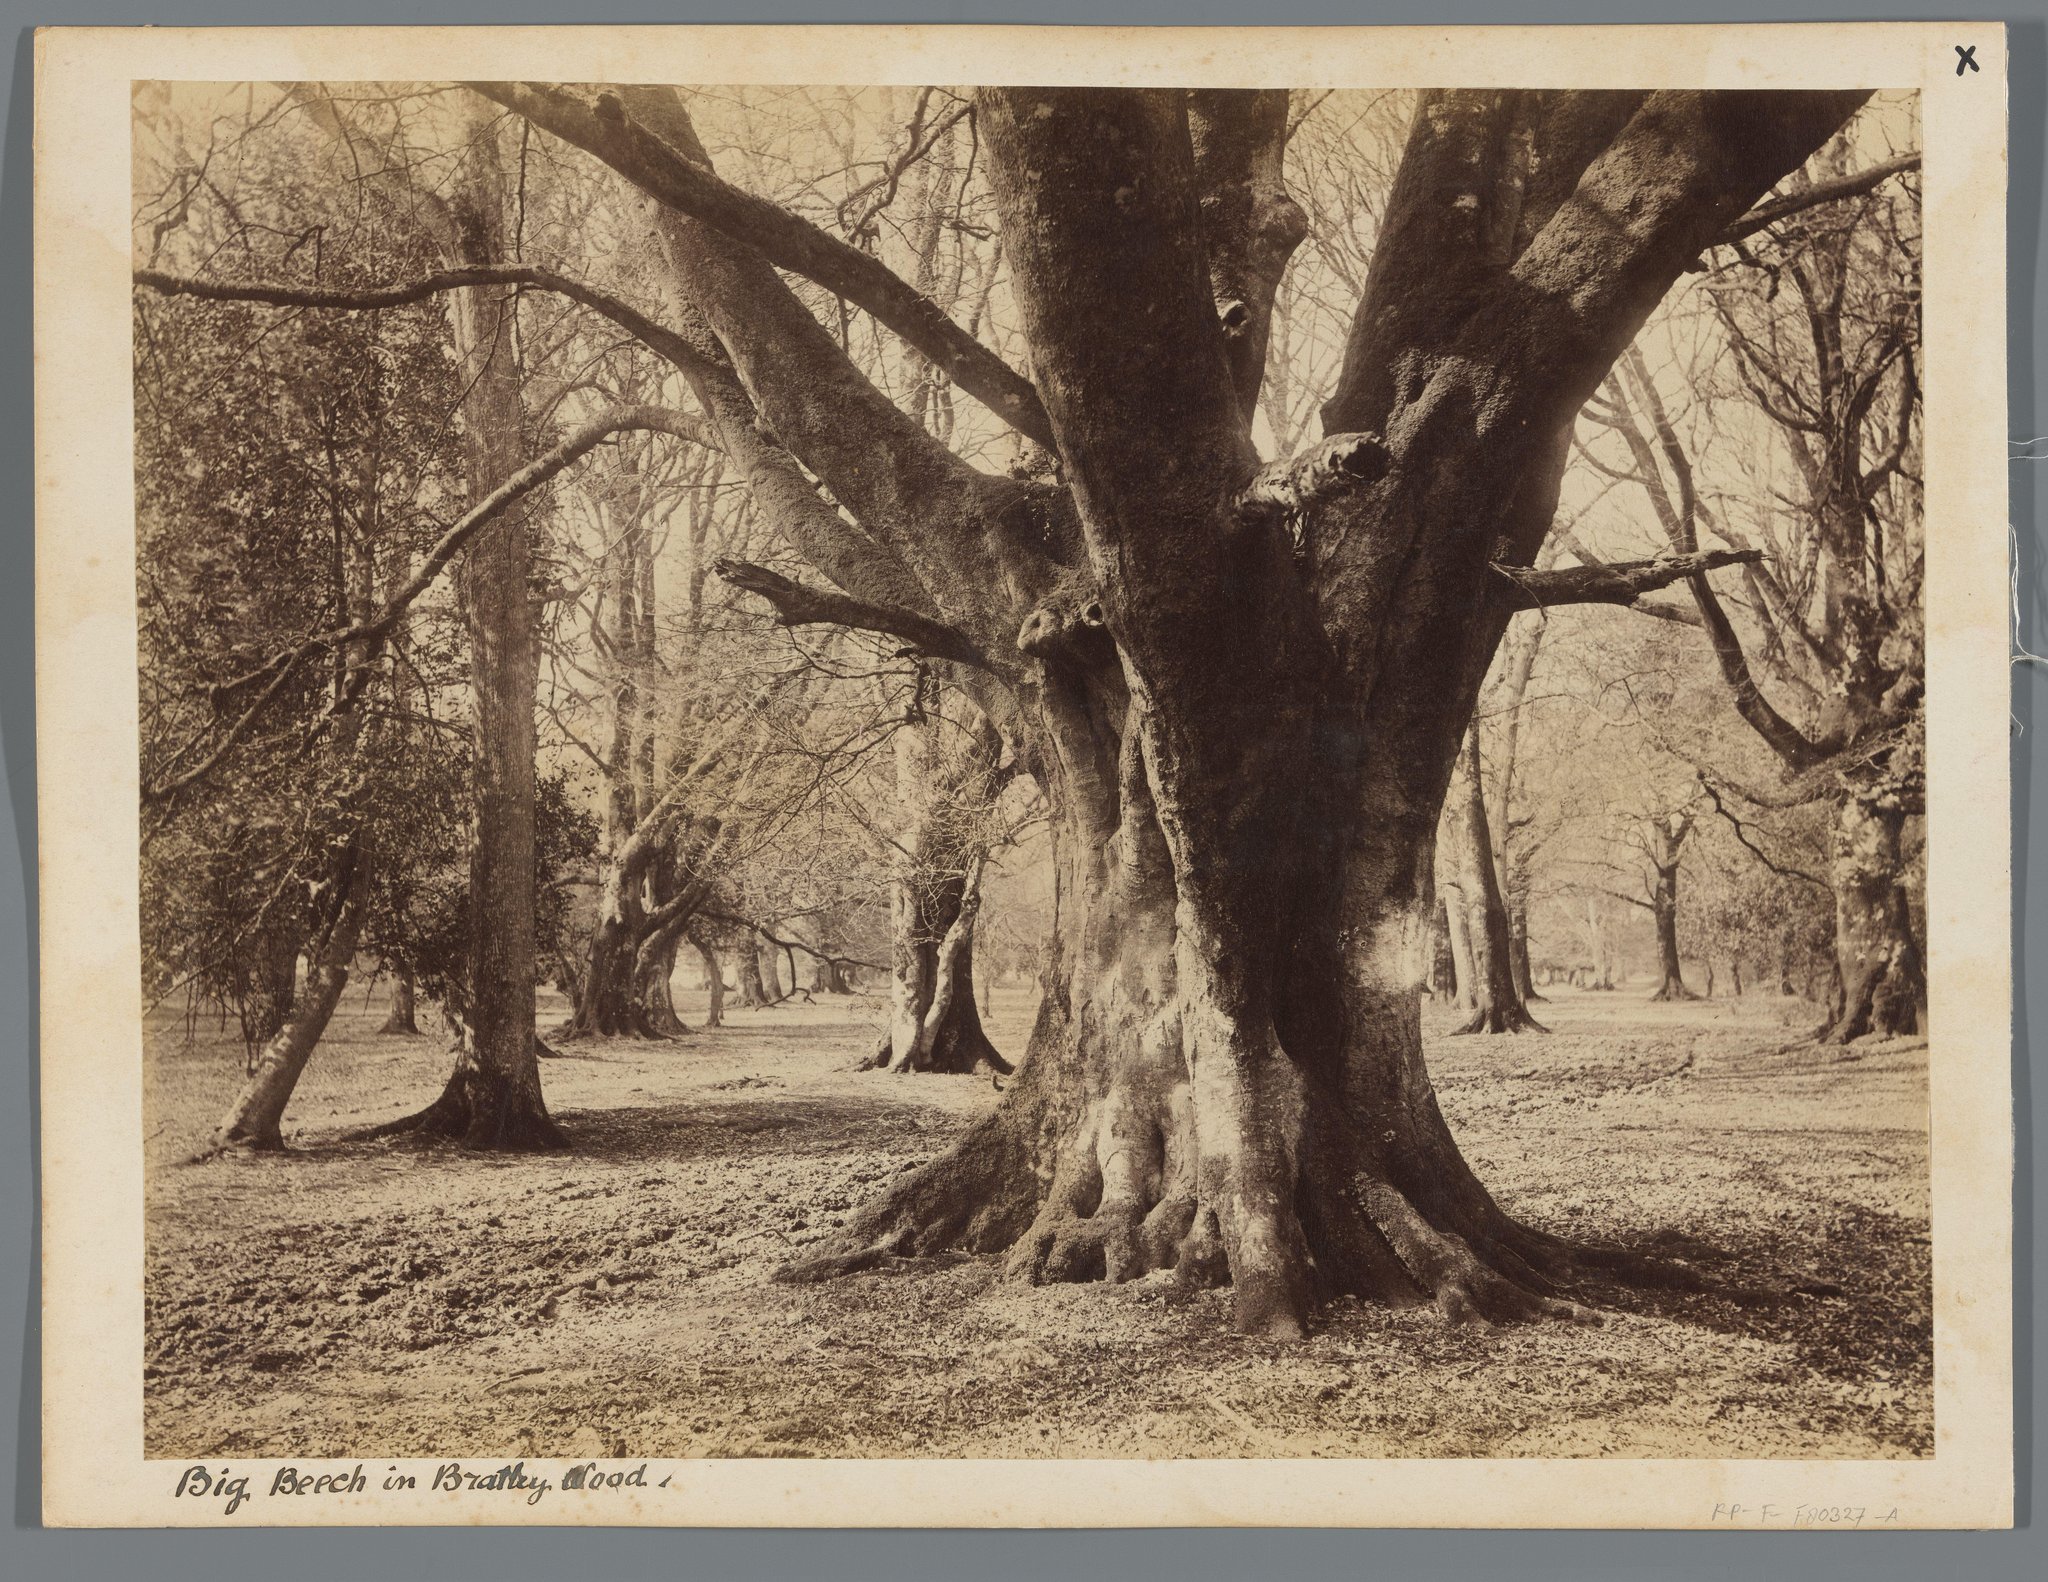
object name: photograph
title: Beuk in Groot-Brittannië, mogelijk in Bradley Woods, Wiltshire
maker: Anonymous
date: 1851-1900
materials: paper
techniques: albumen print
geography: wiltshire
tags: trees